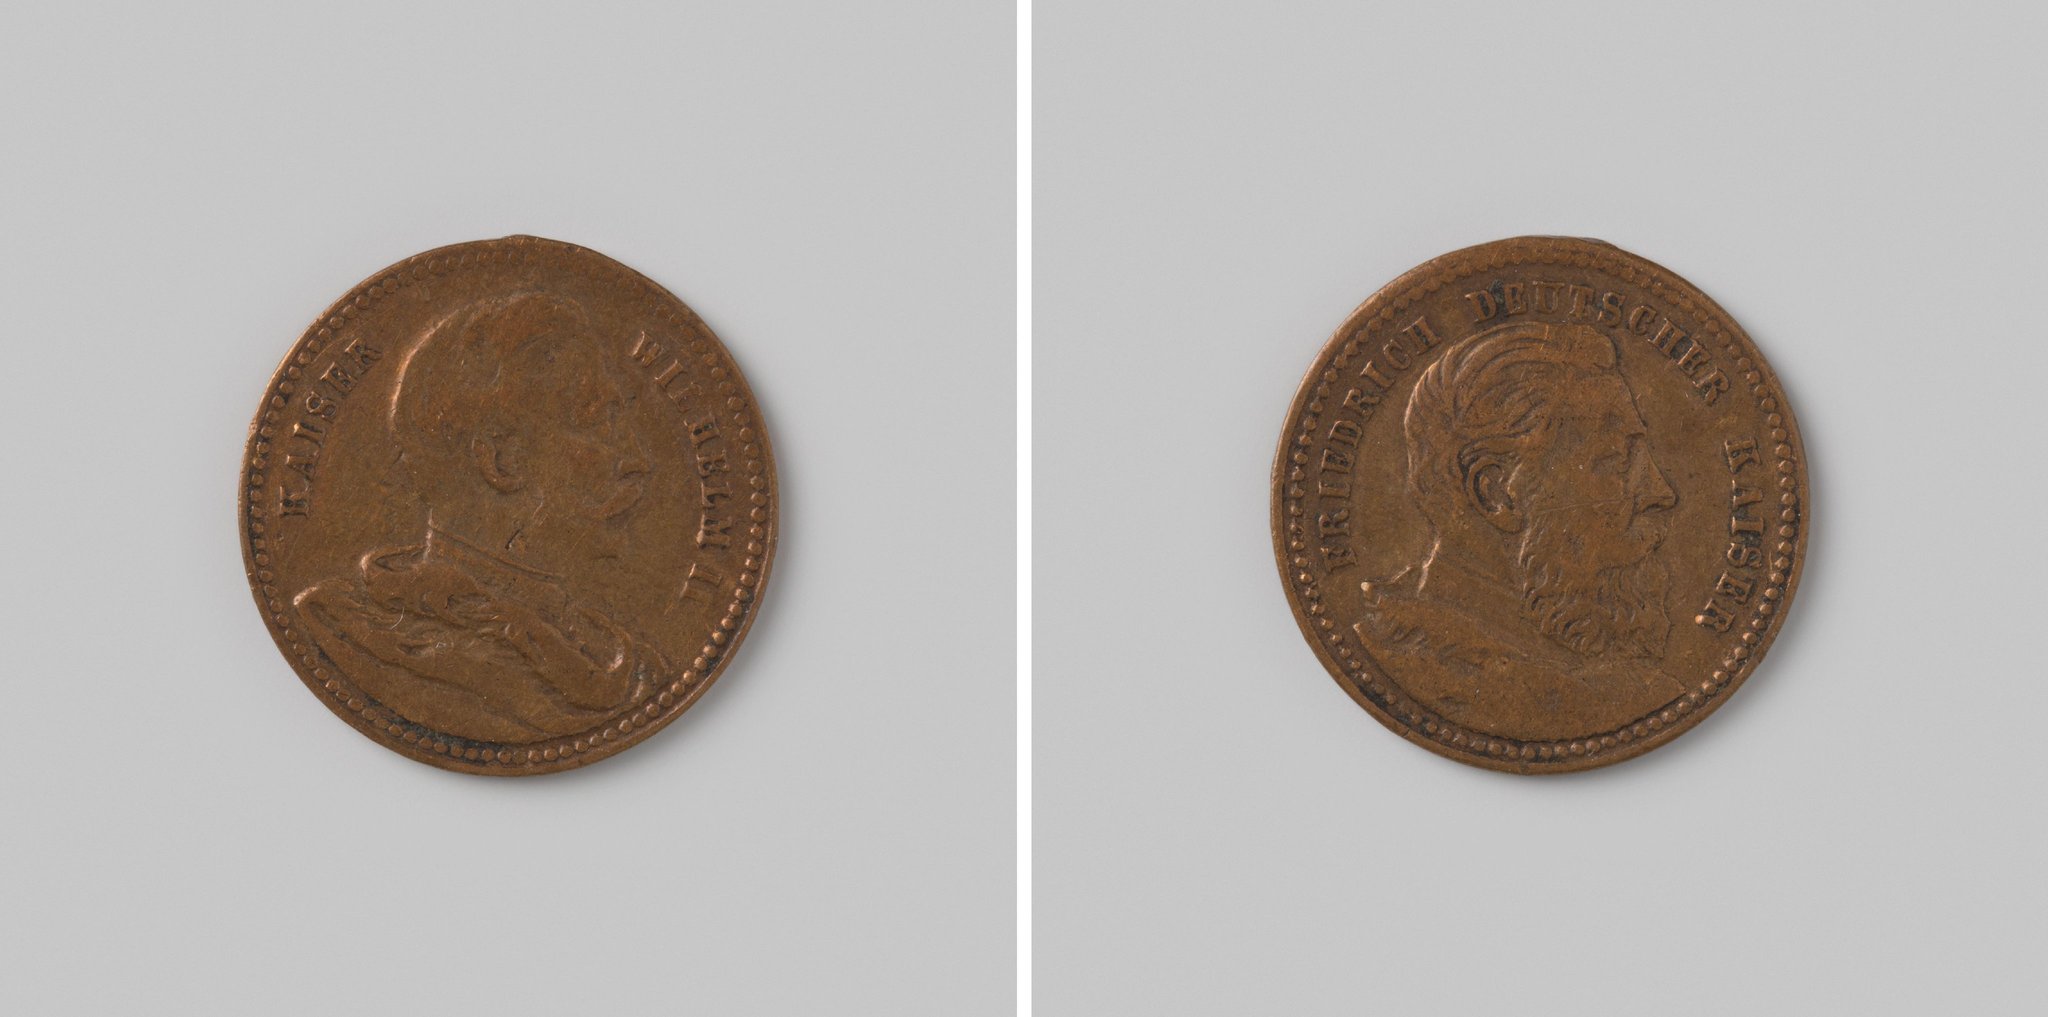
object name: history medal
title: Driekeizerjaar in Duitsland 1888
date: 1888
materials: brass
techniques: striking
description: Messing penning met verwijderd draagoog, op de voorzijde het borstbeeld van Wilhelm II naar rechts met omschrift, op de keerrzijde het borstbeeld van Frederik III naar rechts met omschrift.